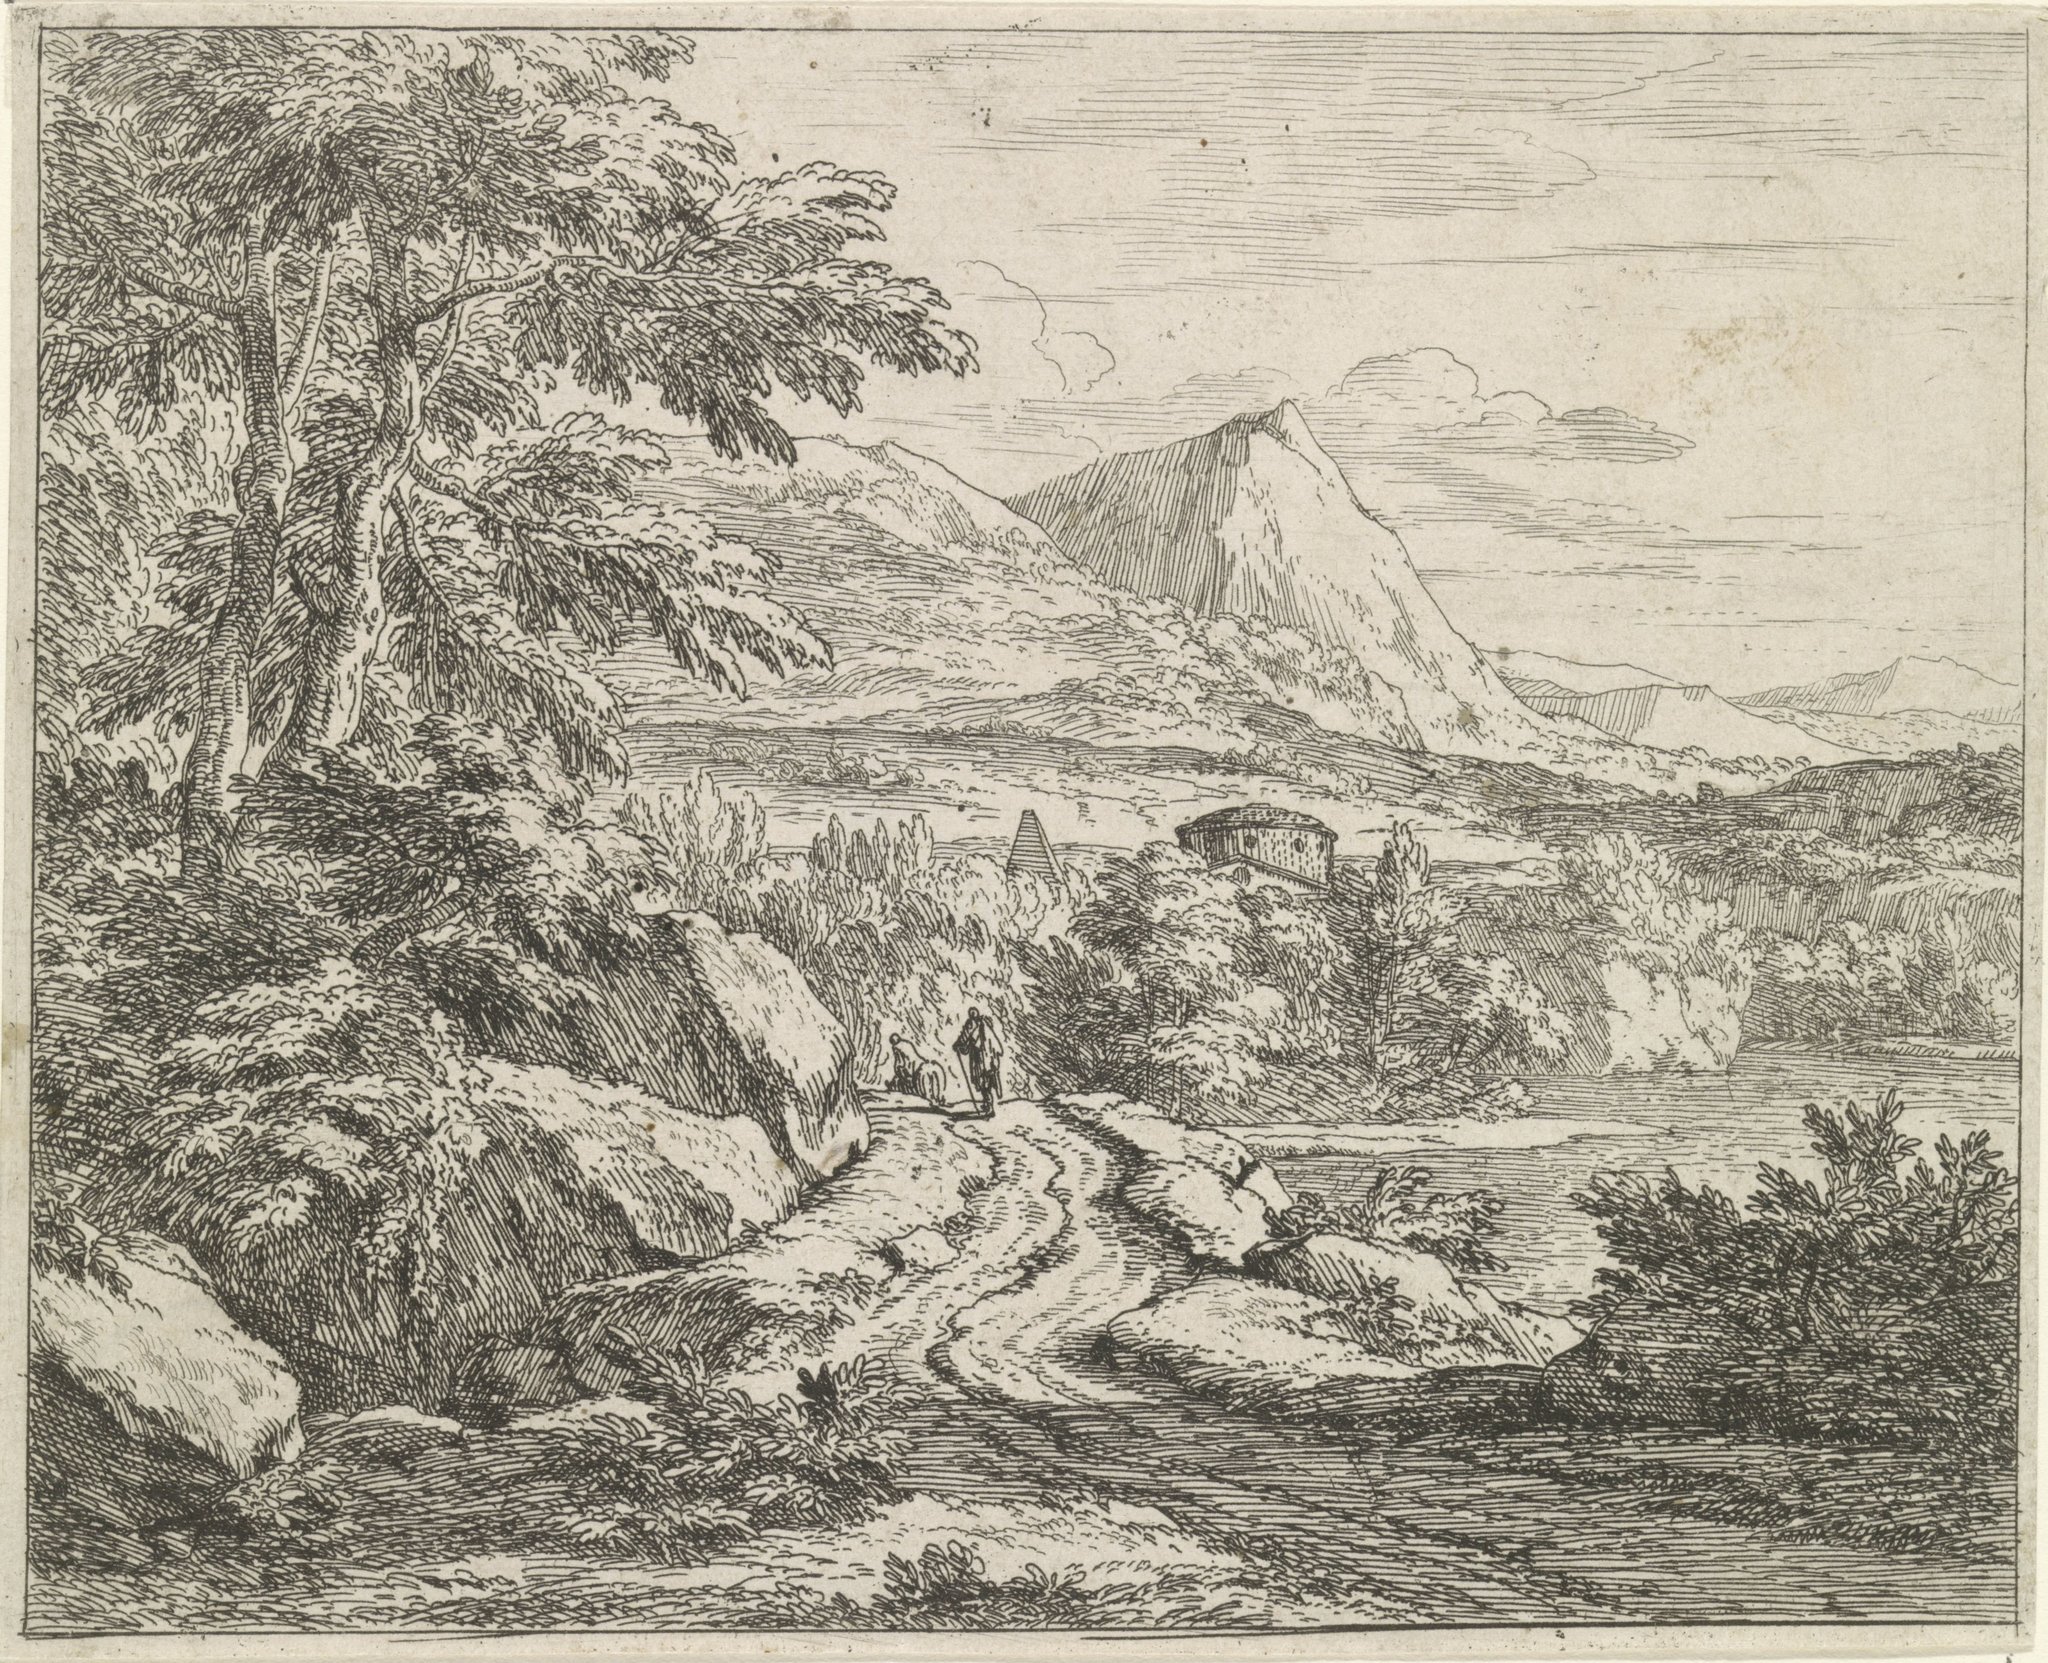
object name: print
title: Landschappen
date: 1650-1690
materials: paper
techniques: etching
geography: paris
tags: rocks, public road (+ city(-scape) with figures, staffage), mountains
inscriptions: collector's mark: Lugt 2228, collector's mark: ‘Cirkel in blauw met schild in het midden.’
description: Een weg langs rotsen. Rechts een meertje. In de verte een bergachtig landschap met een villa. De prent maakt deel uit van serie van zes landschappen.